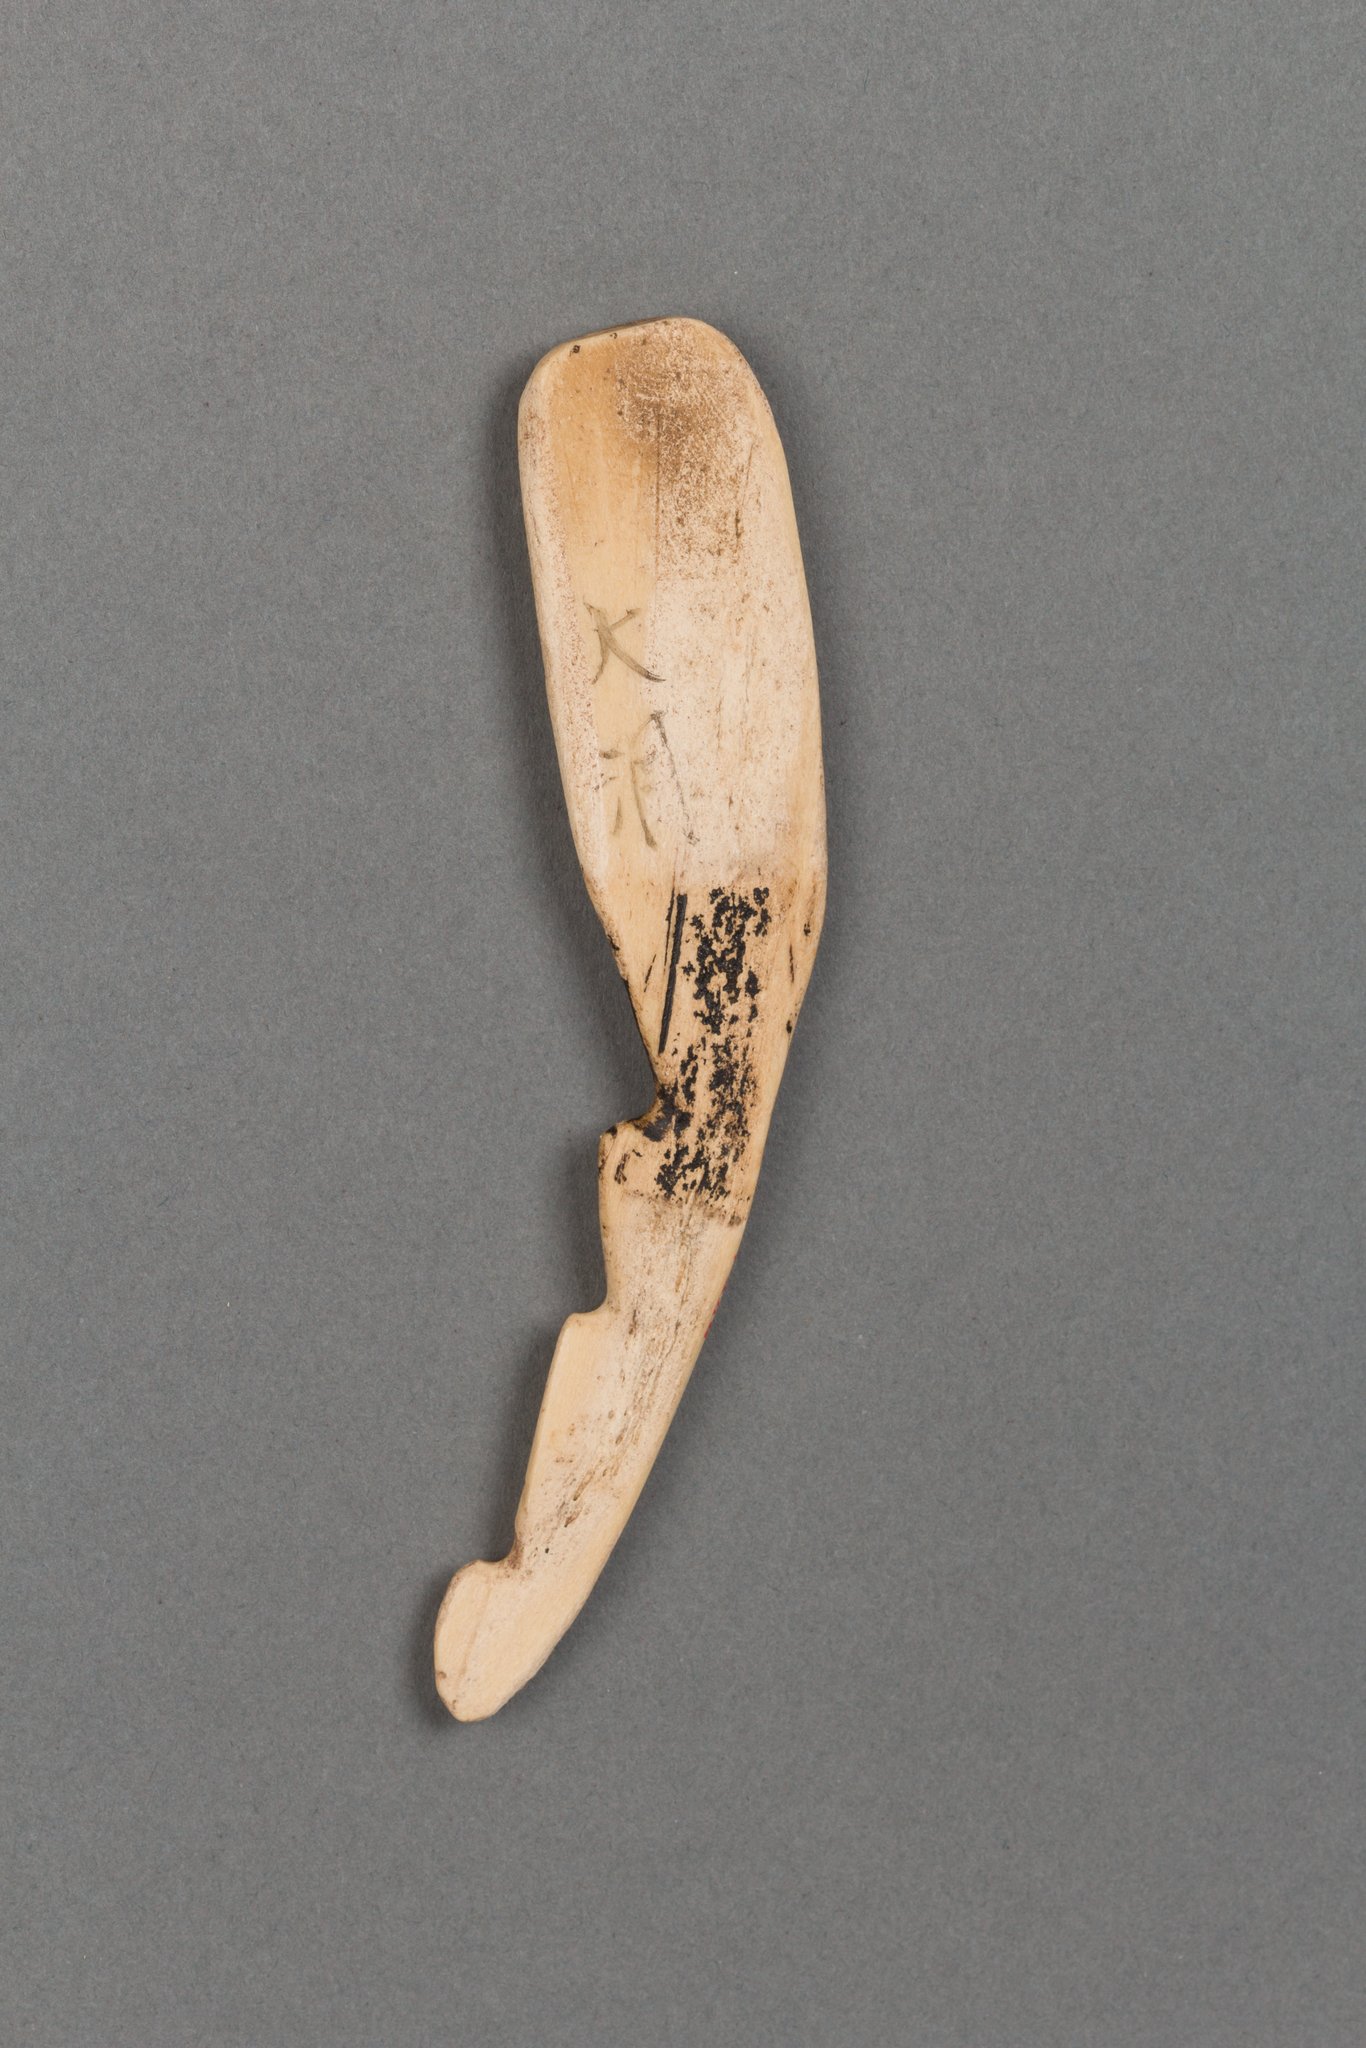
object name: harpoon head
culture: japanese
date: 1200-200 BCE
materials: bone